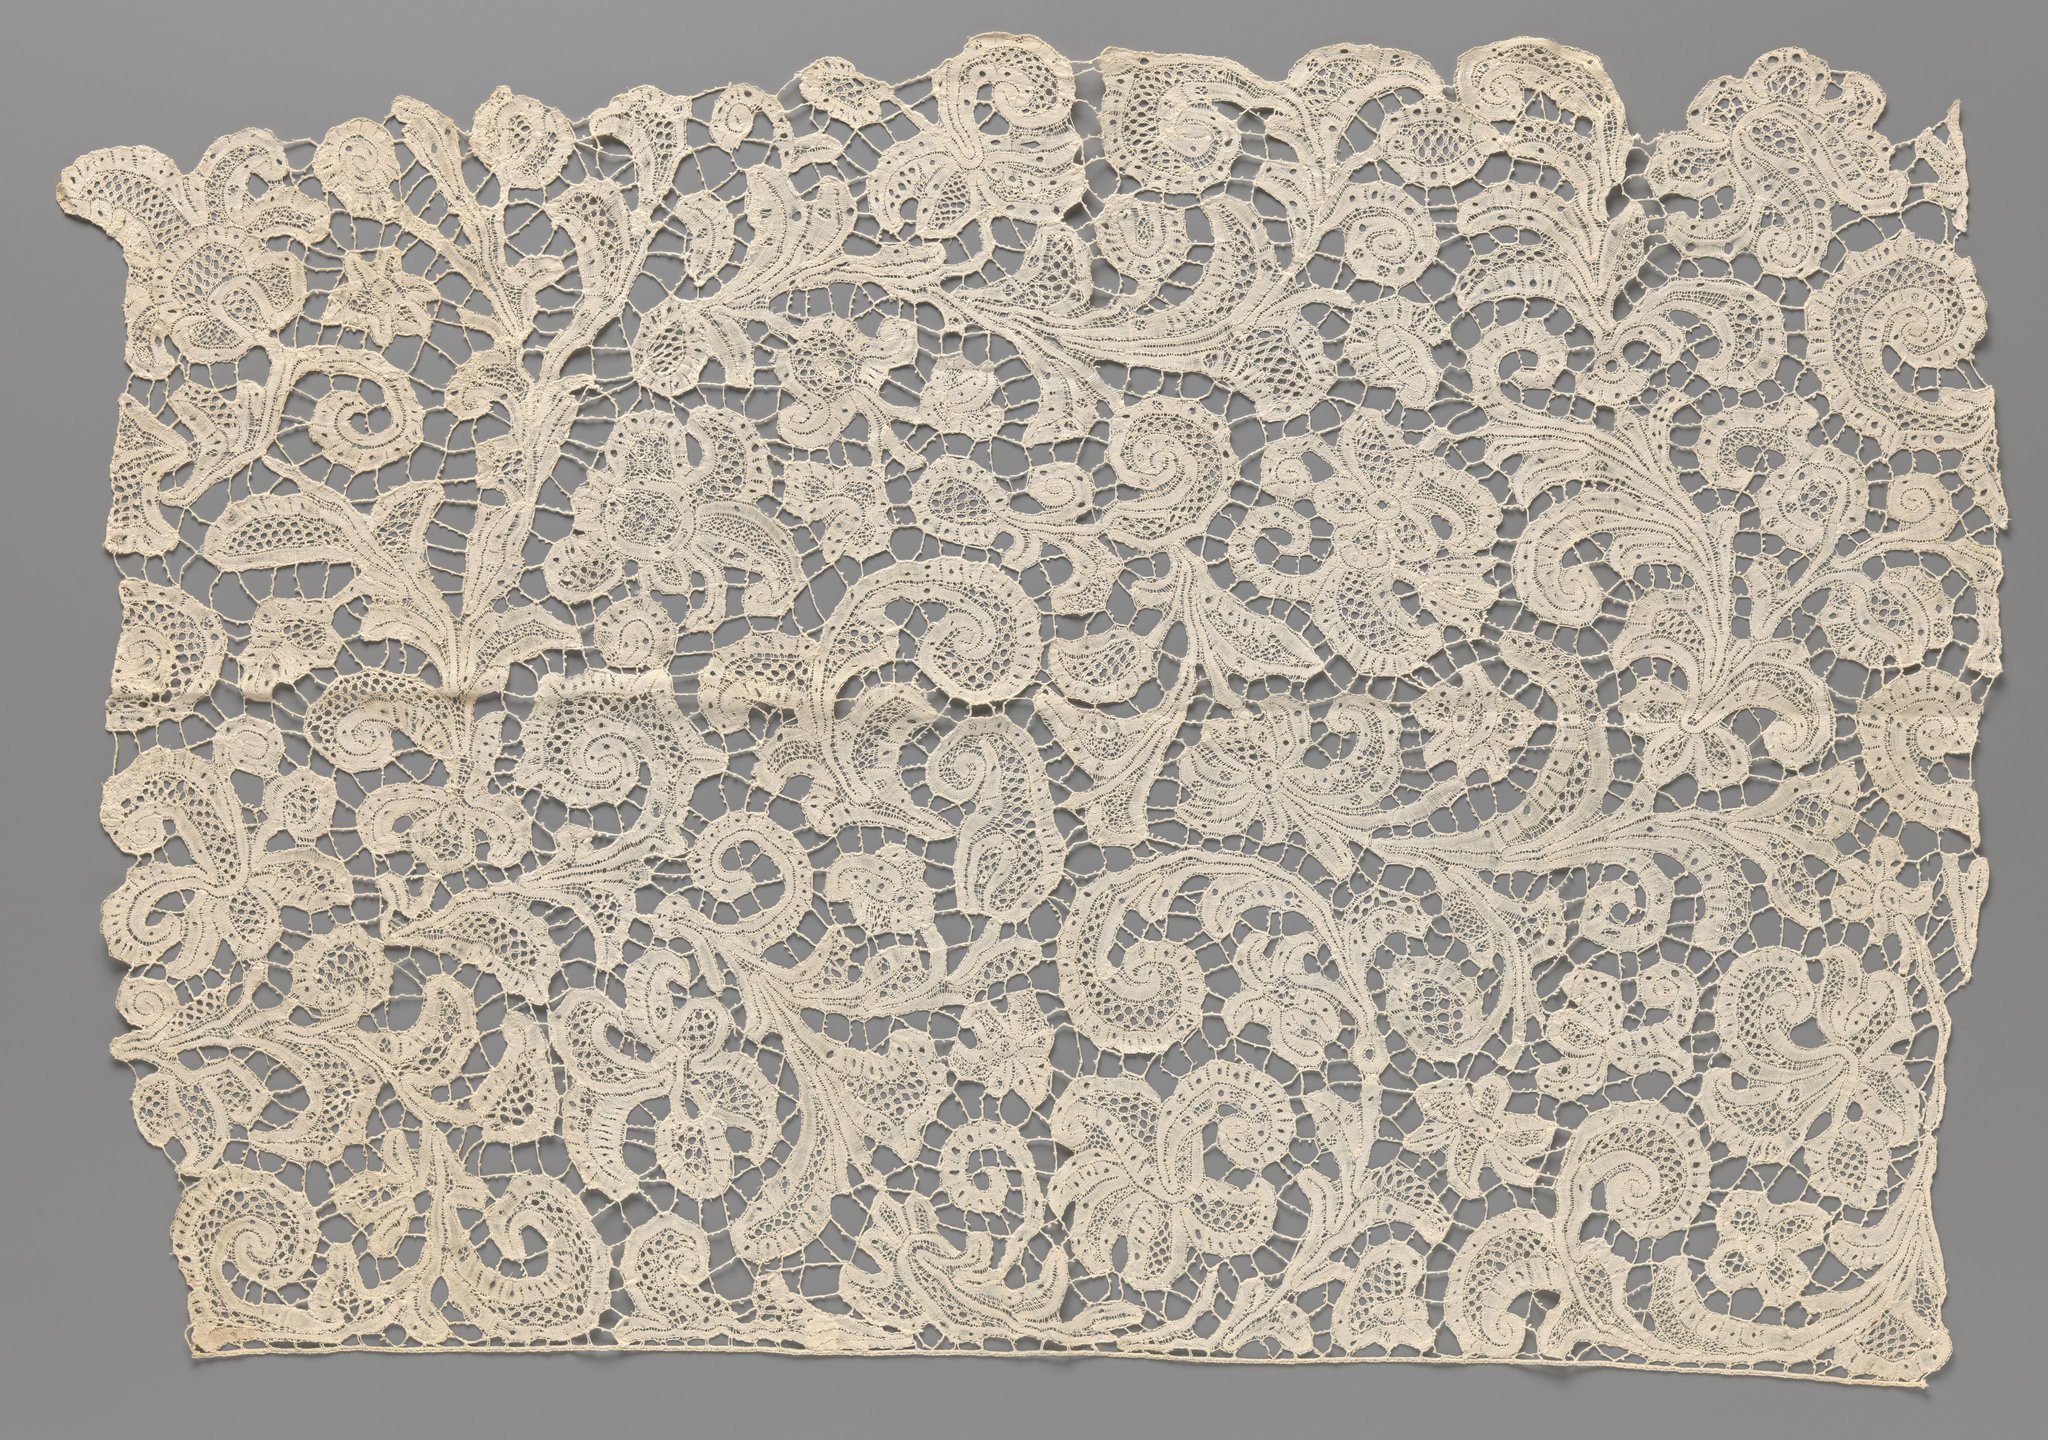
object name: albestrook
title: Albestrook (deel) van kloskant met gevederde bladeren en palmetbloemen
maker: Anonymous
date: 1680-1699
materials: linen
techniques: lace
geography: milan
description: Albestrook (deel) van naturelkleurige kloskant: Milanese kant of oudvlaamse kant met vlechtengrond. Patroon met grote krullende ranken met gevederde bladeren en palmetbloemen. De motieven zijn met elkaar verbonden door een vlechtengrond, met lange gepicoteerde vlechten. De omtrek van de bloemen en bladeren is gemaakt in linnenslag met uitsparingen en binnen deze contouren zijn verschillende siergronden toegepast. De bovenzijde van de strook is recht afgewerkt, de onderzijde volgt de lijnen van het patroon.